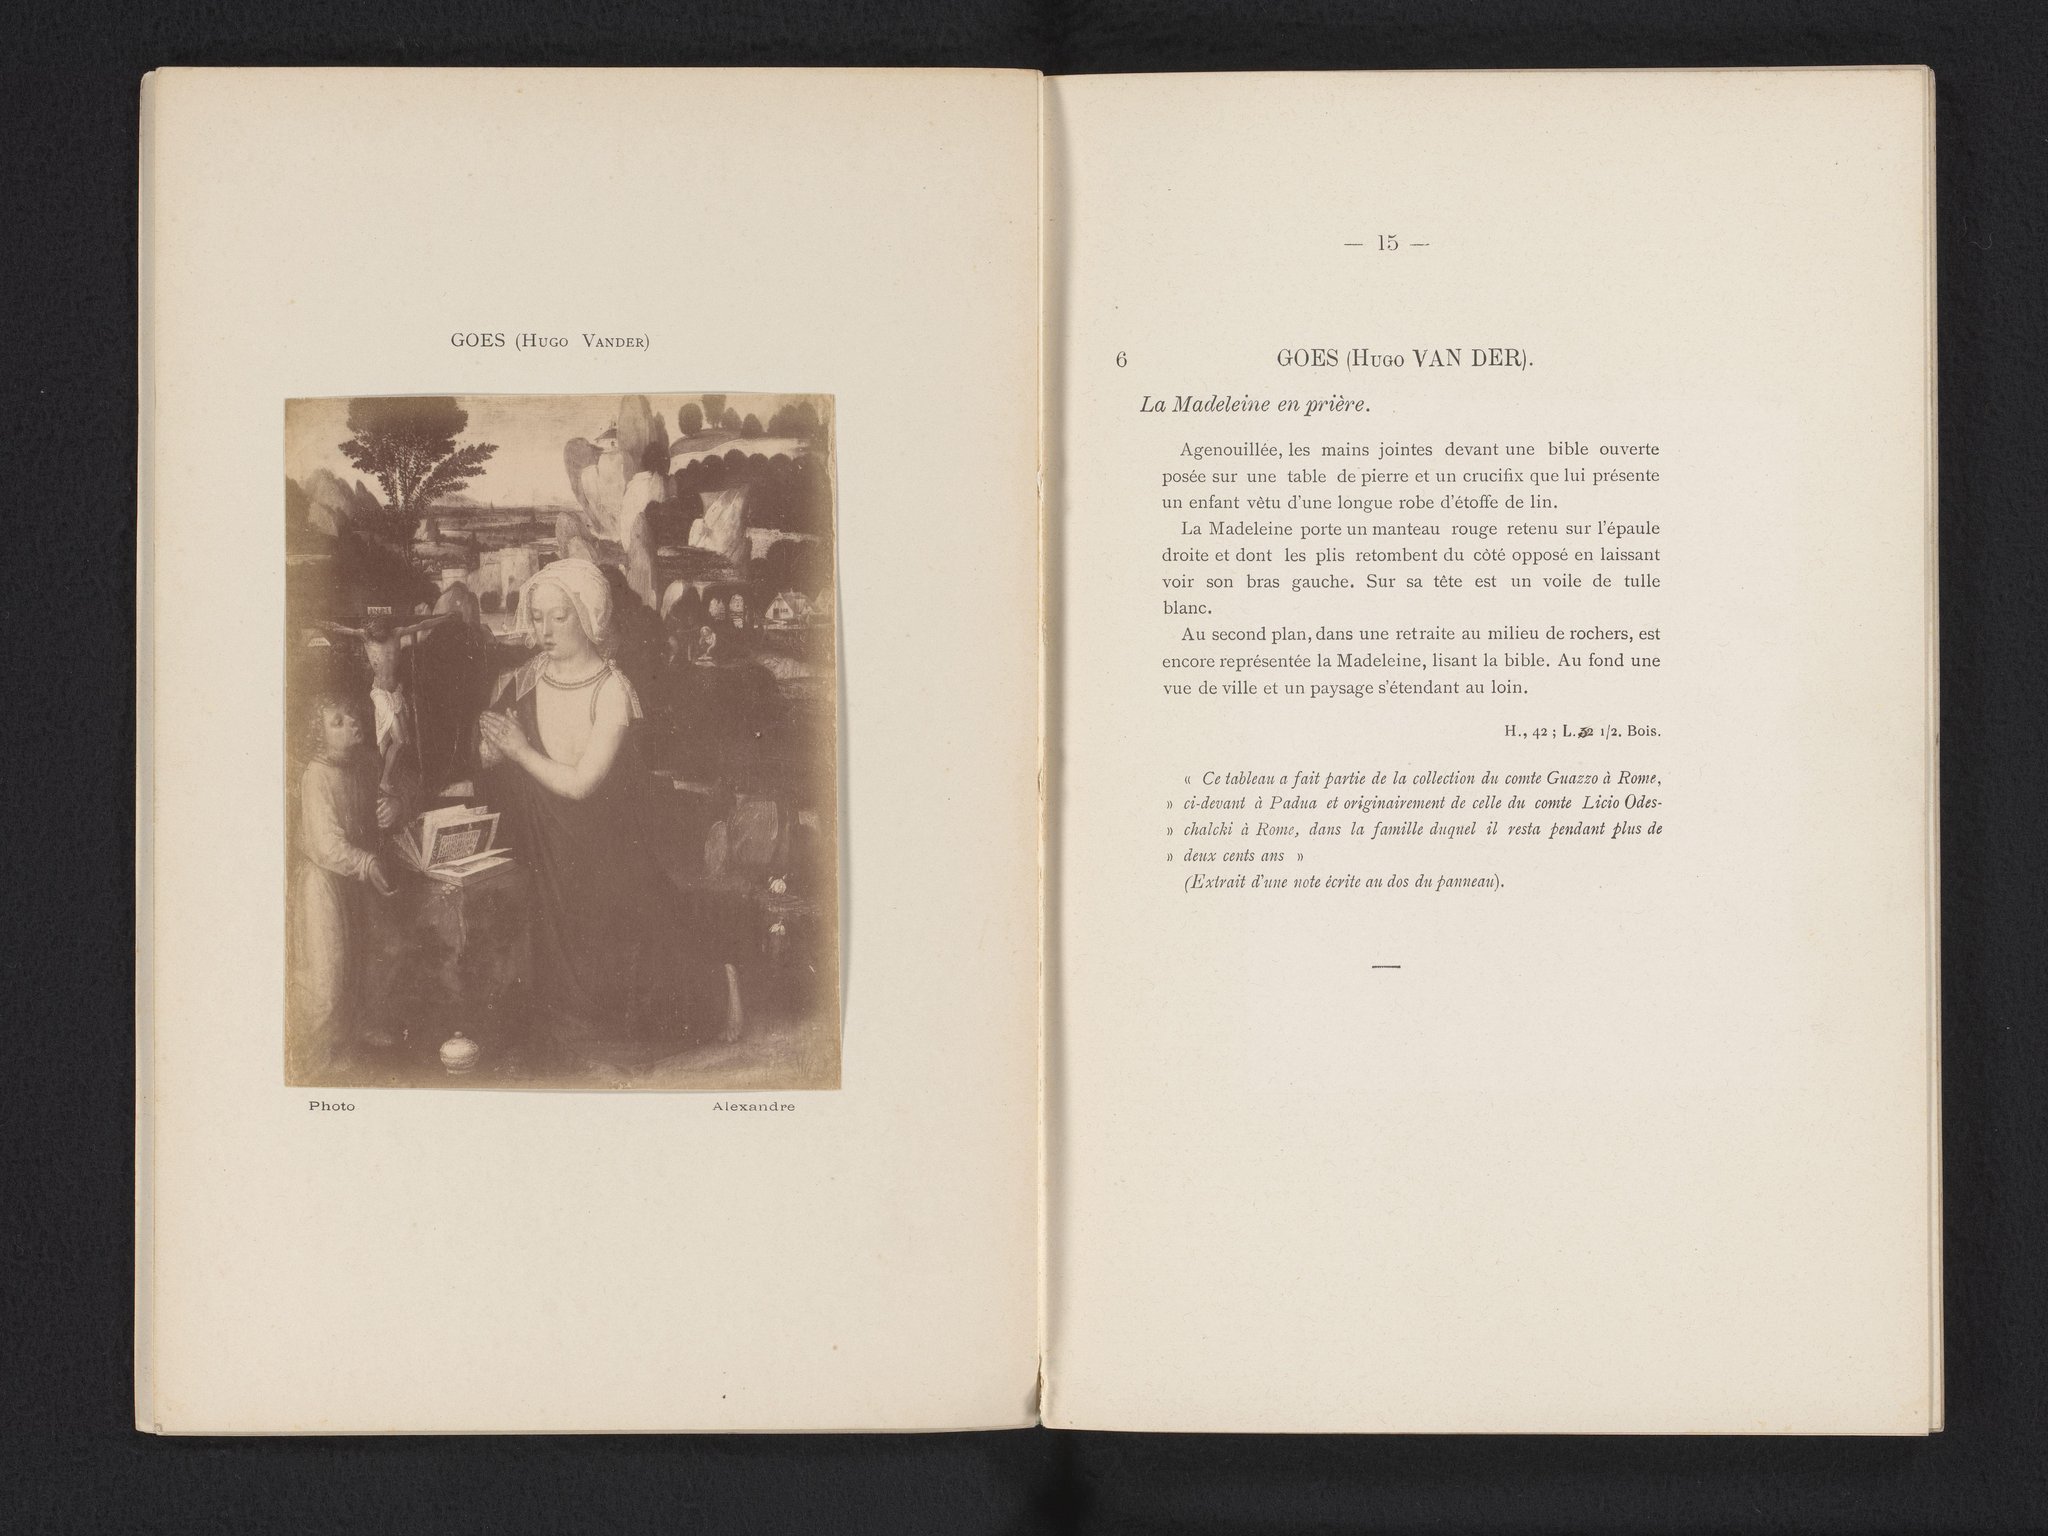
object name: page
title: Fotoreproductie van een schilderij van Maria Magdalena in een landschap door Adriaen Isenbrant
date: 1878-1883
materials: photographic support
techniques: albumen print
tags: mary praying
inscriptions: inscription: ‘Goes (Hugo Vander)’